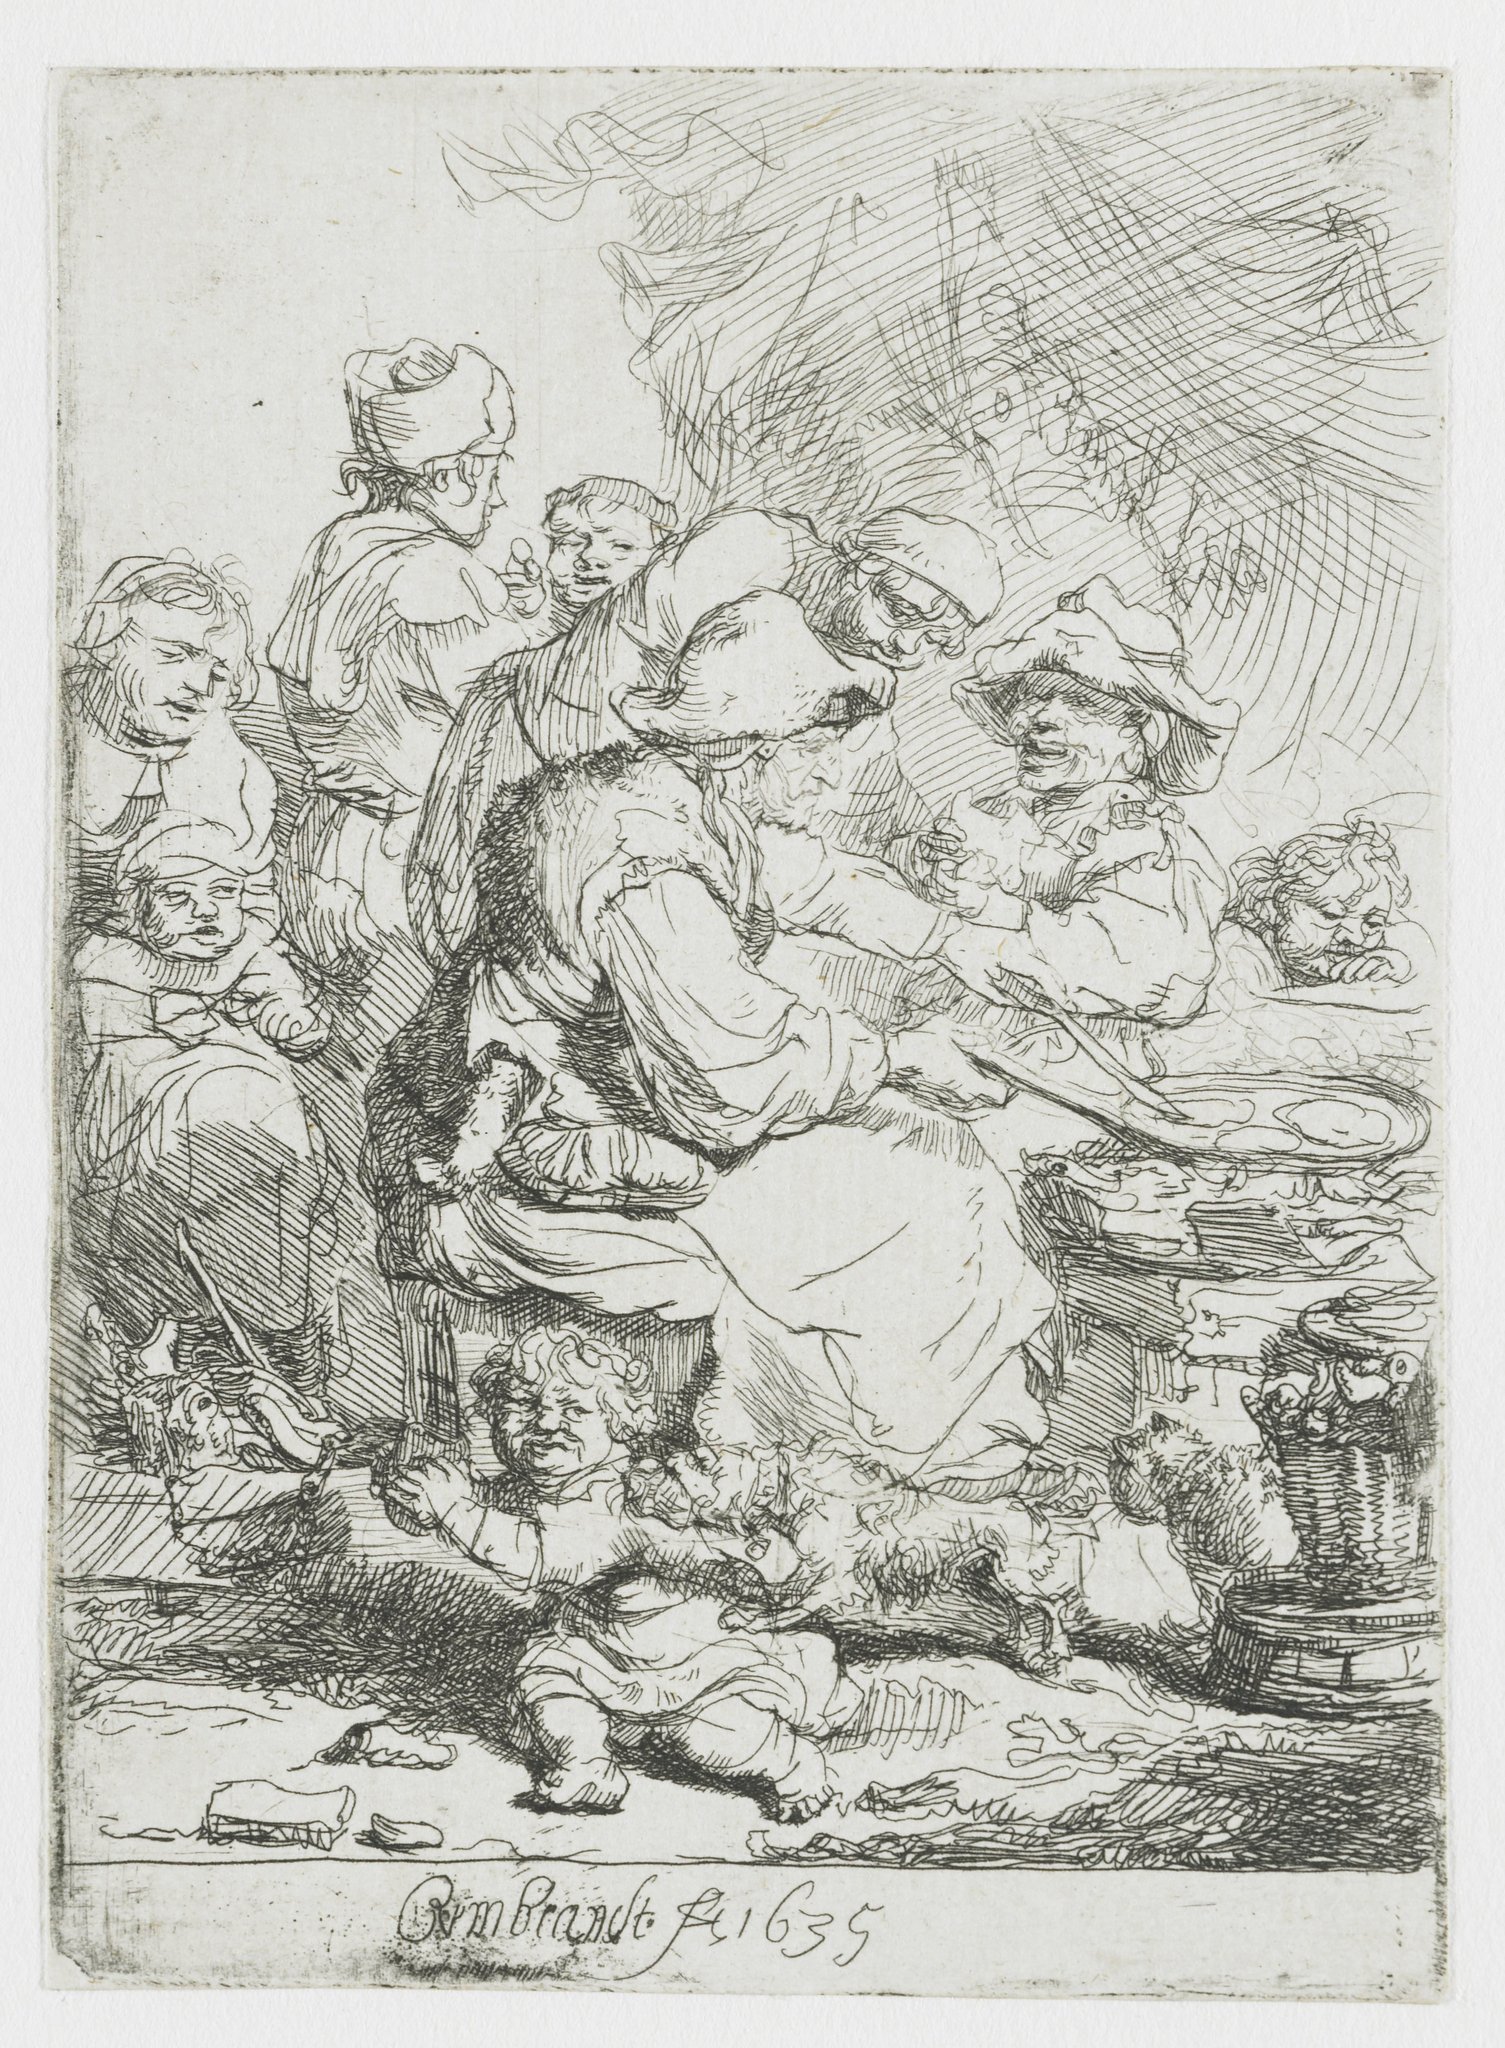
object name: print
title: The pancake woman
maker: rembrandt van rijn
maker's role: draughtsman, painter, print maker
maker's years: 1606-1669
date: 1635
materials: paper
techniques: etching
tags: pancakes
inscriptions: collector's mark: Lugt 240, signature and date: ‘Rembrandt. f 1635’